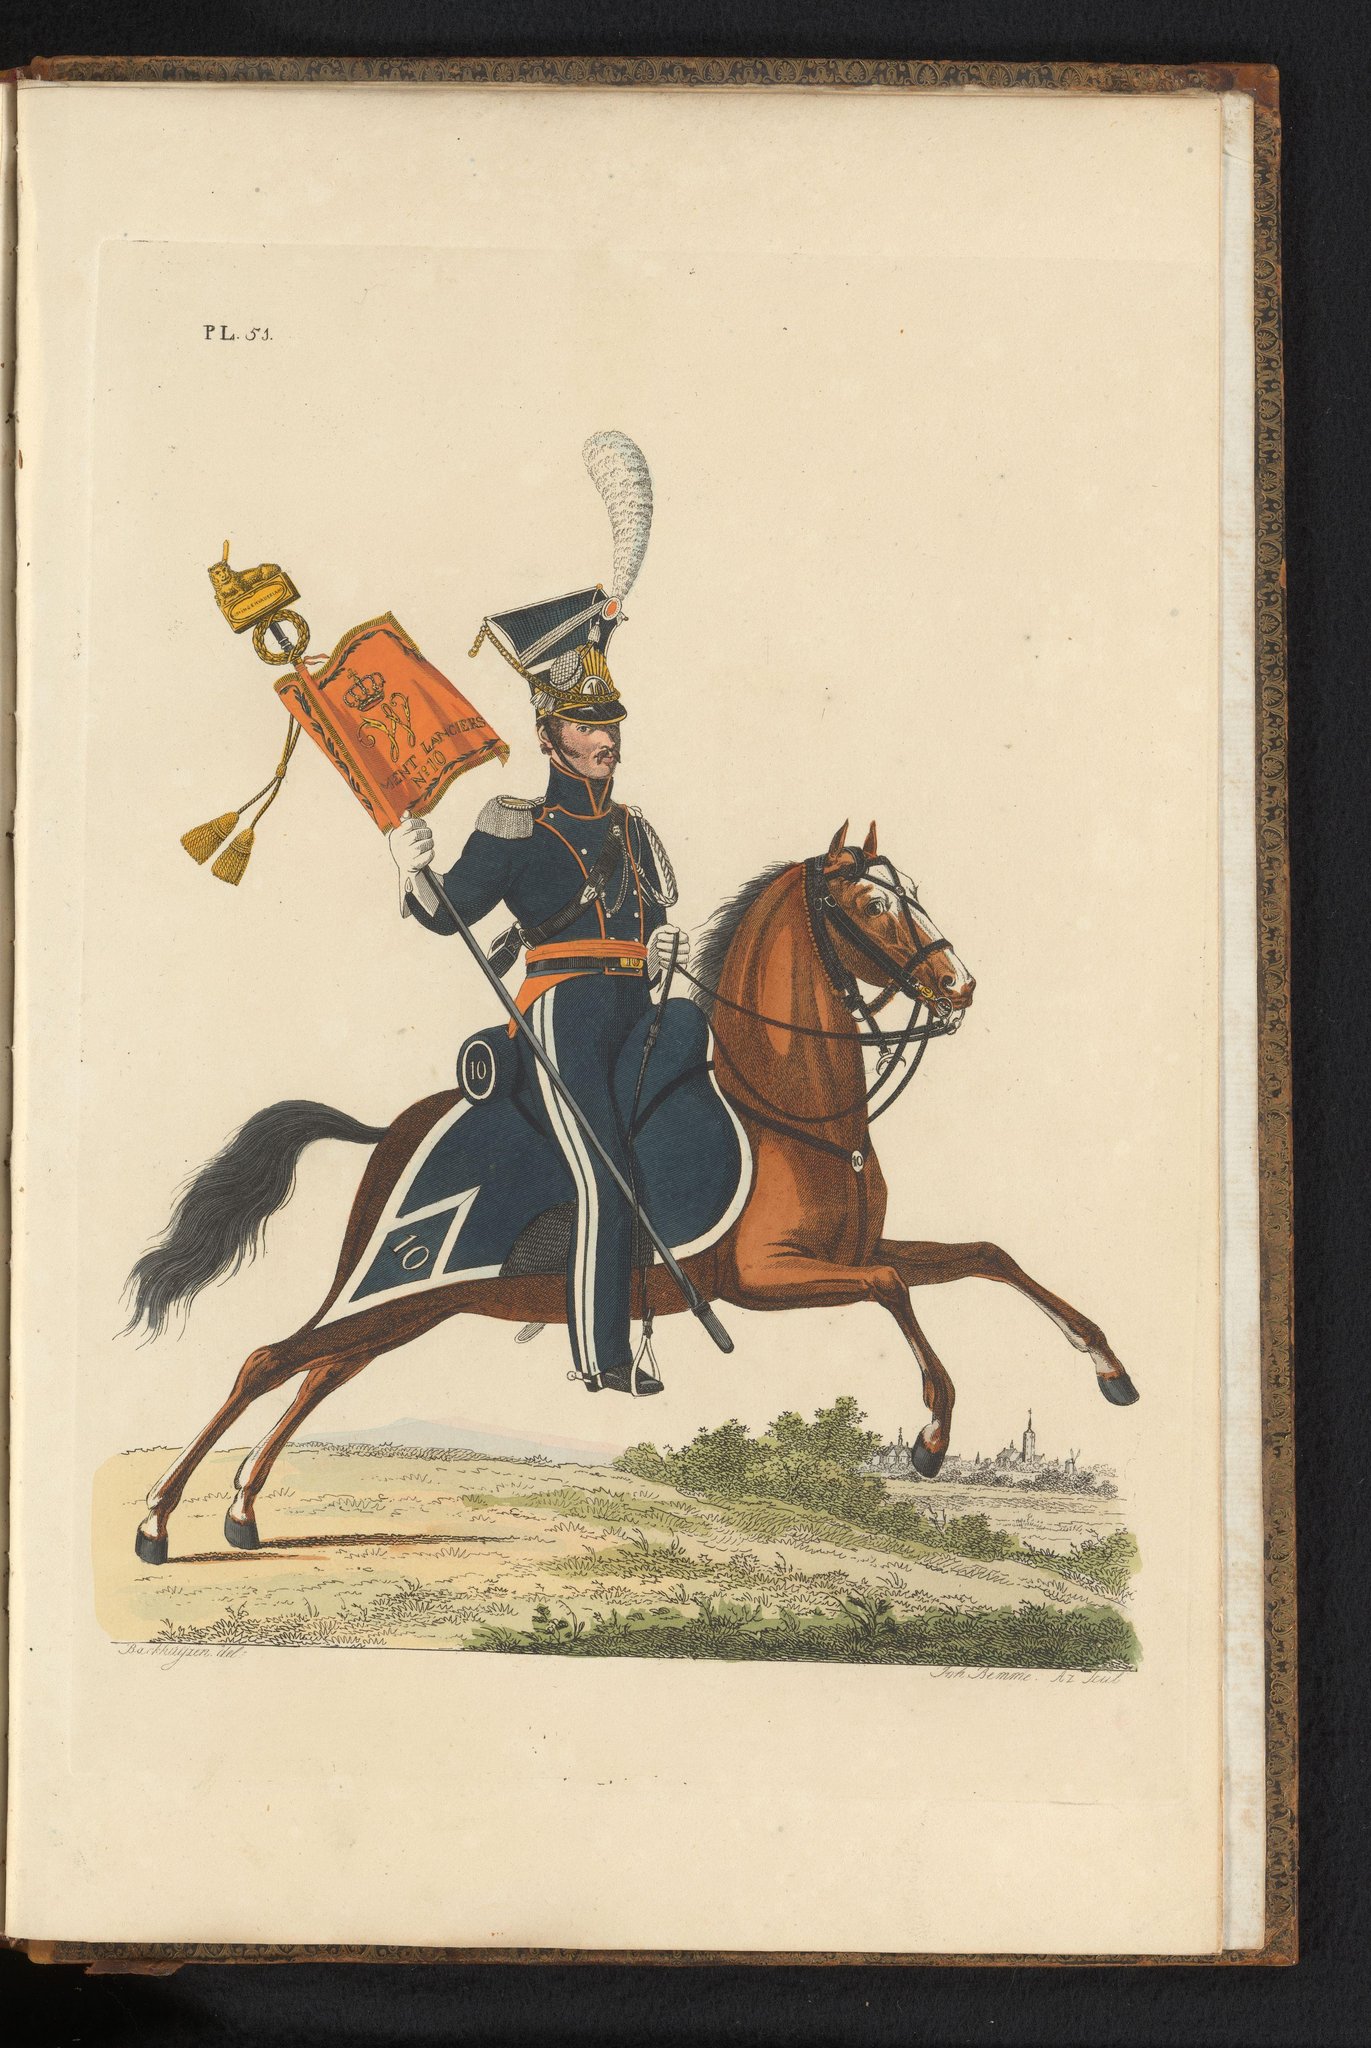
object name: print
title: Cornet der Lanciers, in groote tenue, te paard, met de Standaart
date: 1823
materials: paper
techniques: engraving, etching, hand coloring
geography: netherlands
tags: horn, trumpet, cornet, trombone, tuba, (military) uniforms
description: Een Nederlandse kornet van de lansiers van het Regiment Lansiers Nr 10 in grote tenue en met standaard zittend op een paard. Plaat 51. Uniformvoorstelling in 'Beschrijving hoedanig de Koninklijke Nederlandsche troepen' van J.F. Teupken, 1823.